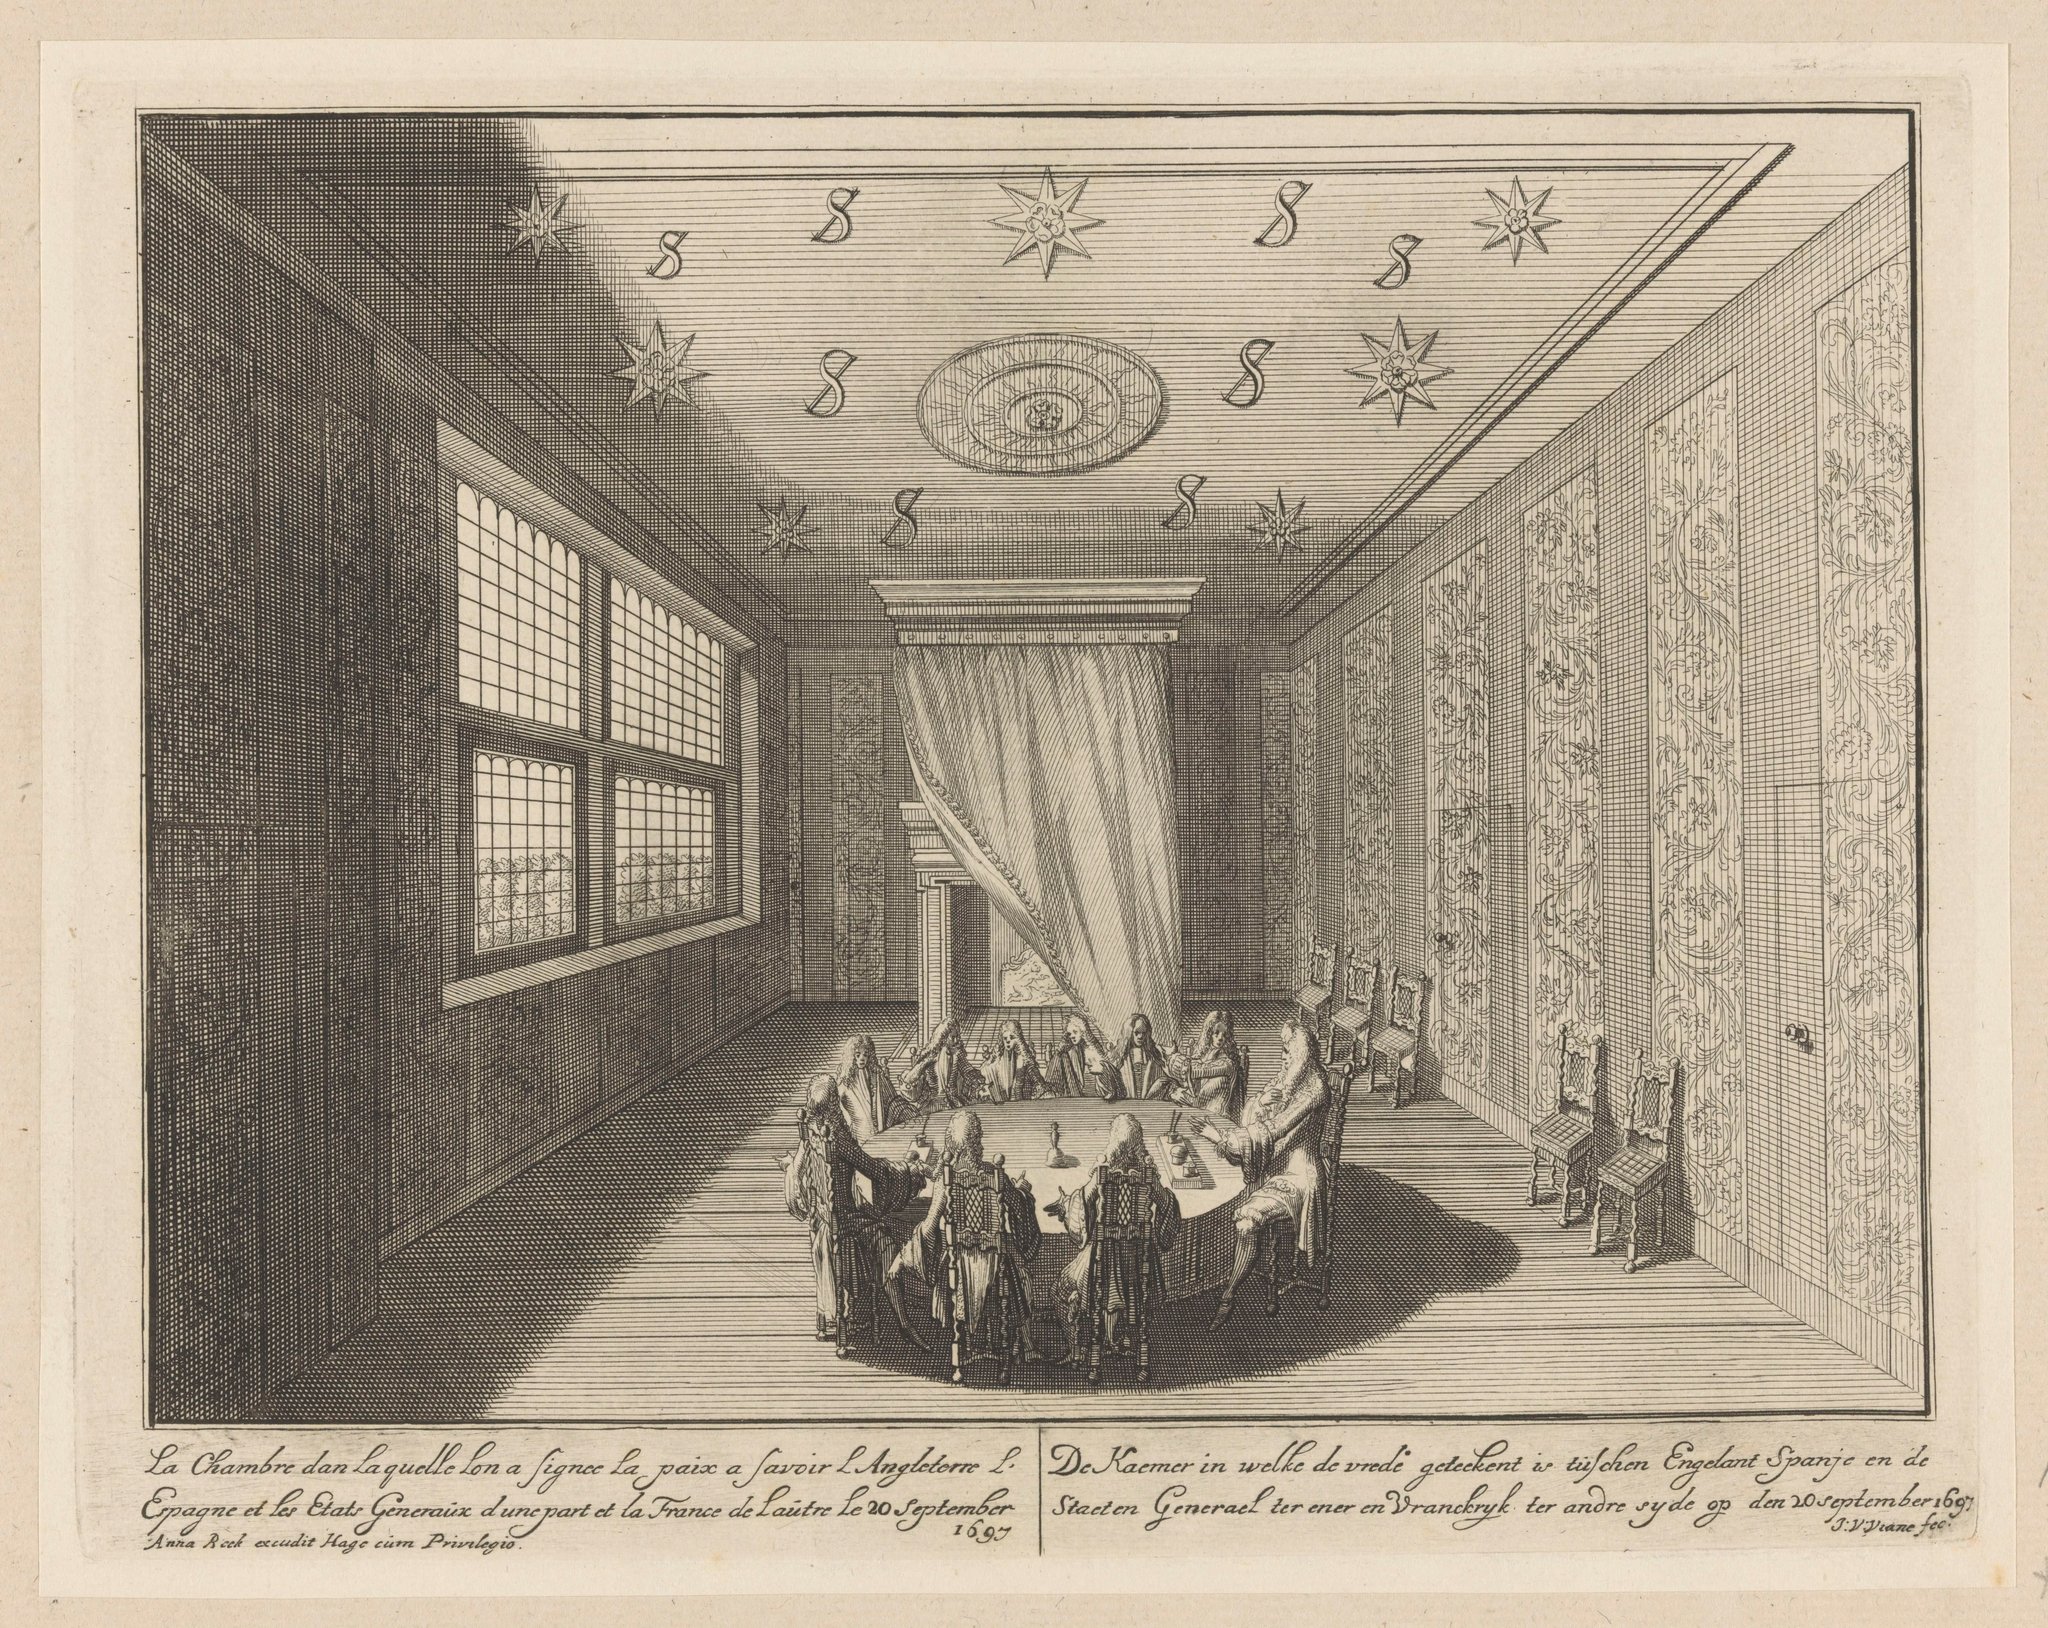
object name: print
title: Kamer waar de vrede is getekend in het Huis ter Nieuburch in Rijswijk, 1697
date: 1697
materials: paper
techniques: etching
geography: northern netherlands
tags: palace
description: De kamer waar het vredesverdrag is ondertekend in het Huis ter Nieuburch in Rijswijk. Een groep mannen gezeten aan een ronde tafel. In het onderschrift de twee titels in het Frans en Nederlands. Onderdeel (prent 12) van de serie van vijftien prenten over het Huis ter Nieuburch in Rijswijk en de daar gehouden vredesonderhandelingen resulterend in de Vrede van Rijswijk gesloten op 20 september 1697.